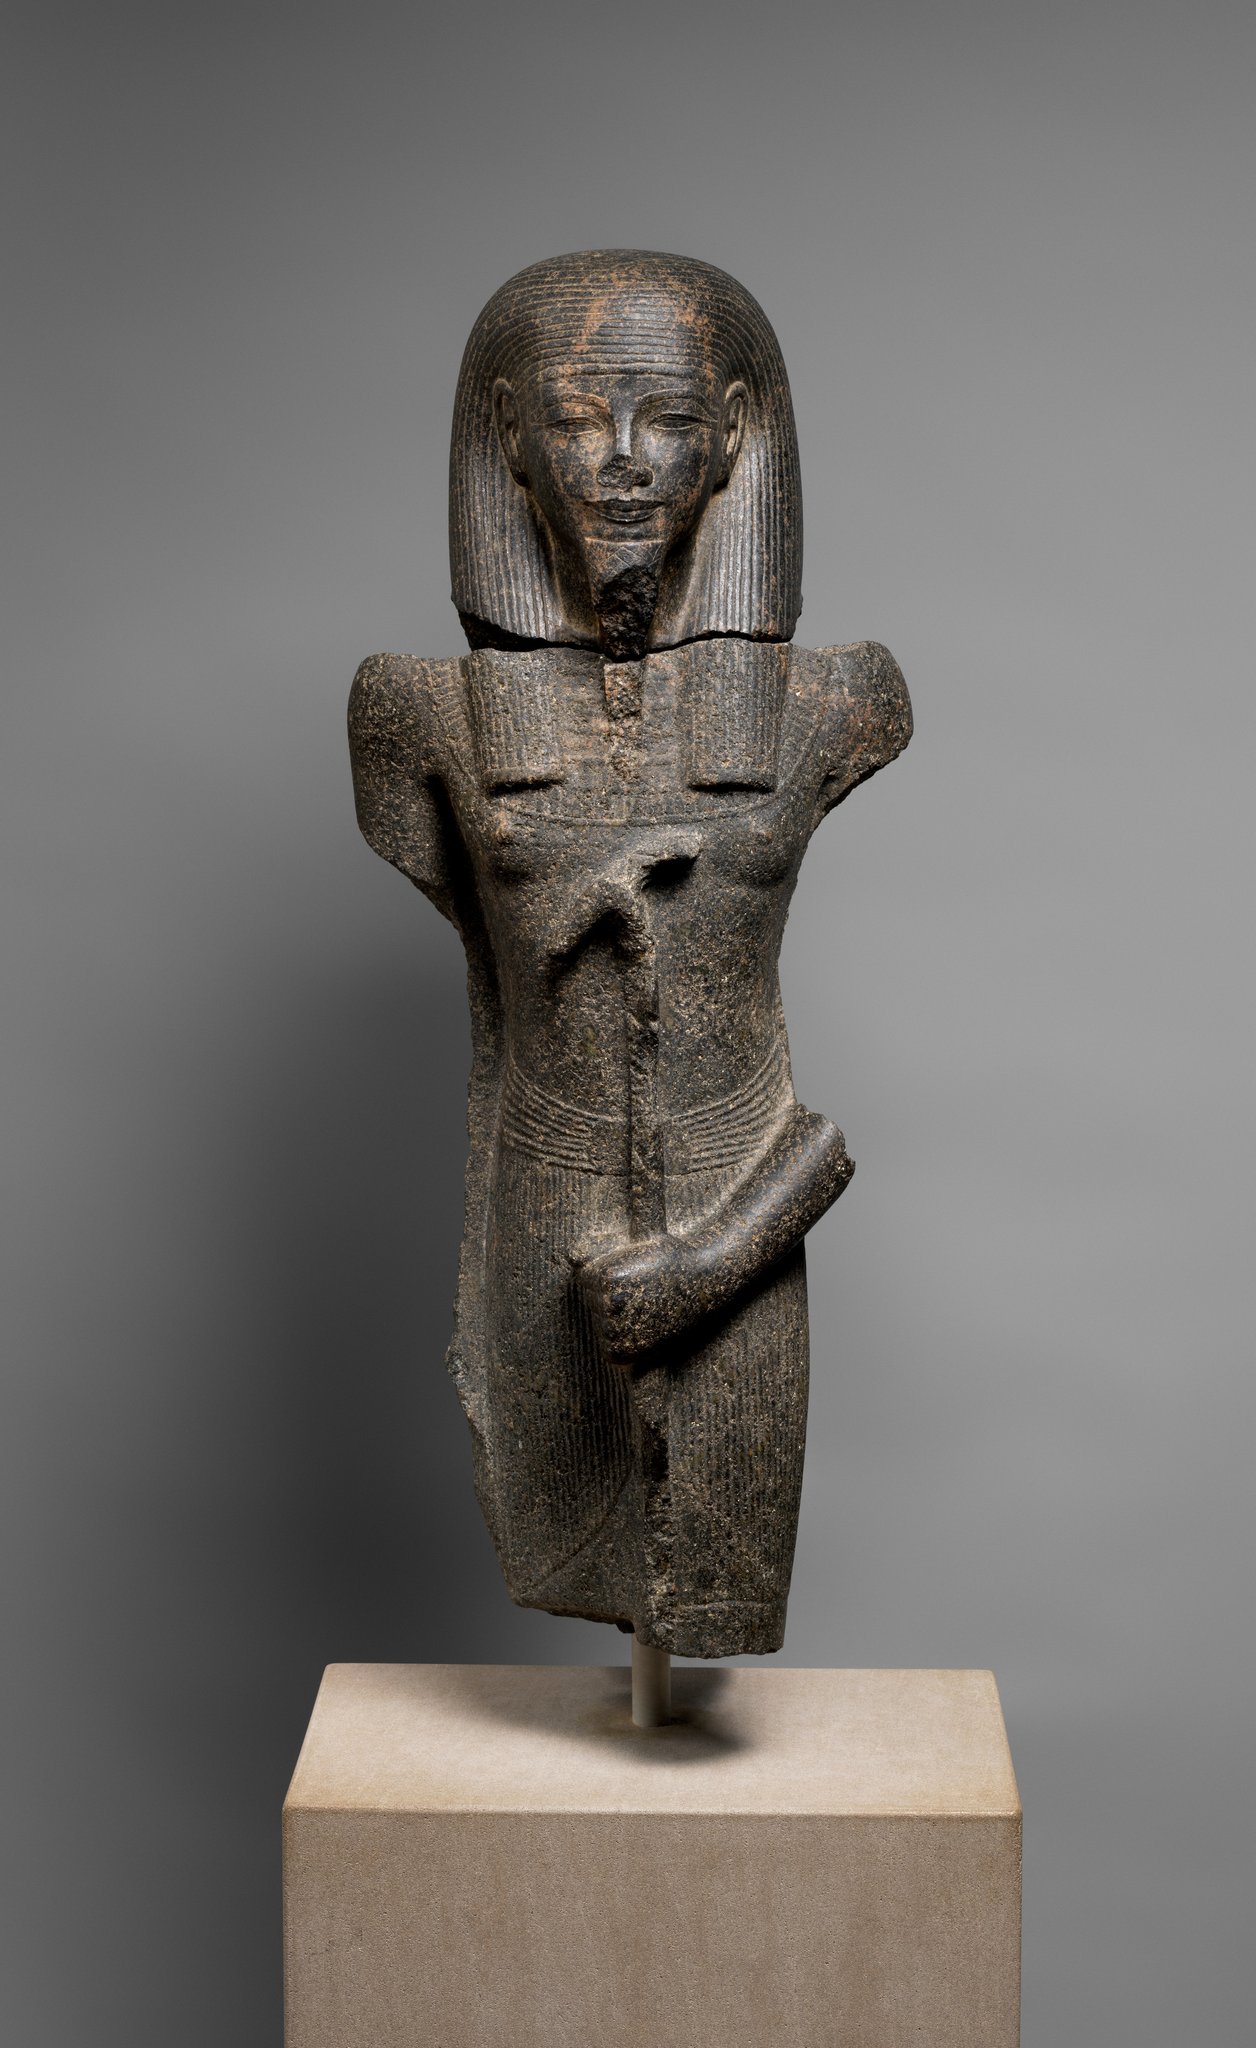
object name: statue, god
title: Male god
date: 1390-1352 BCE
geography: egypt